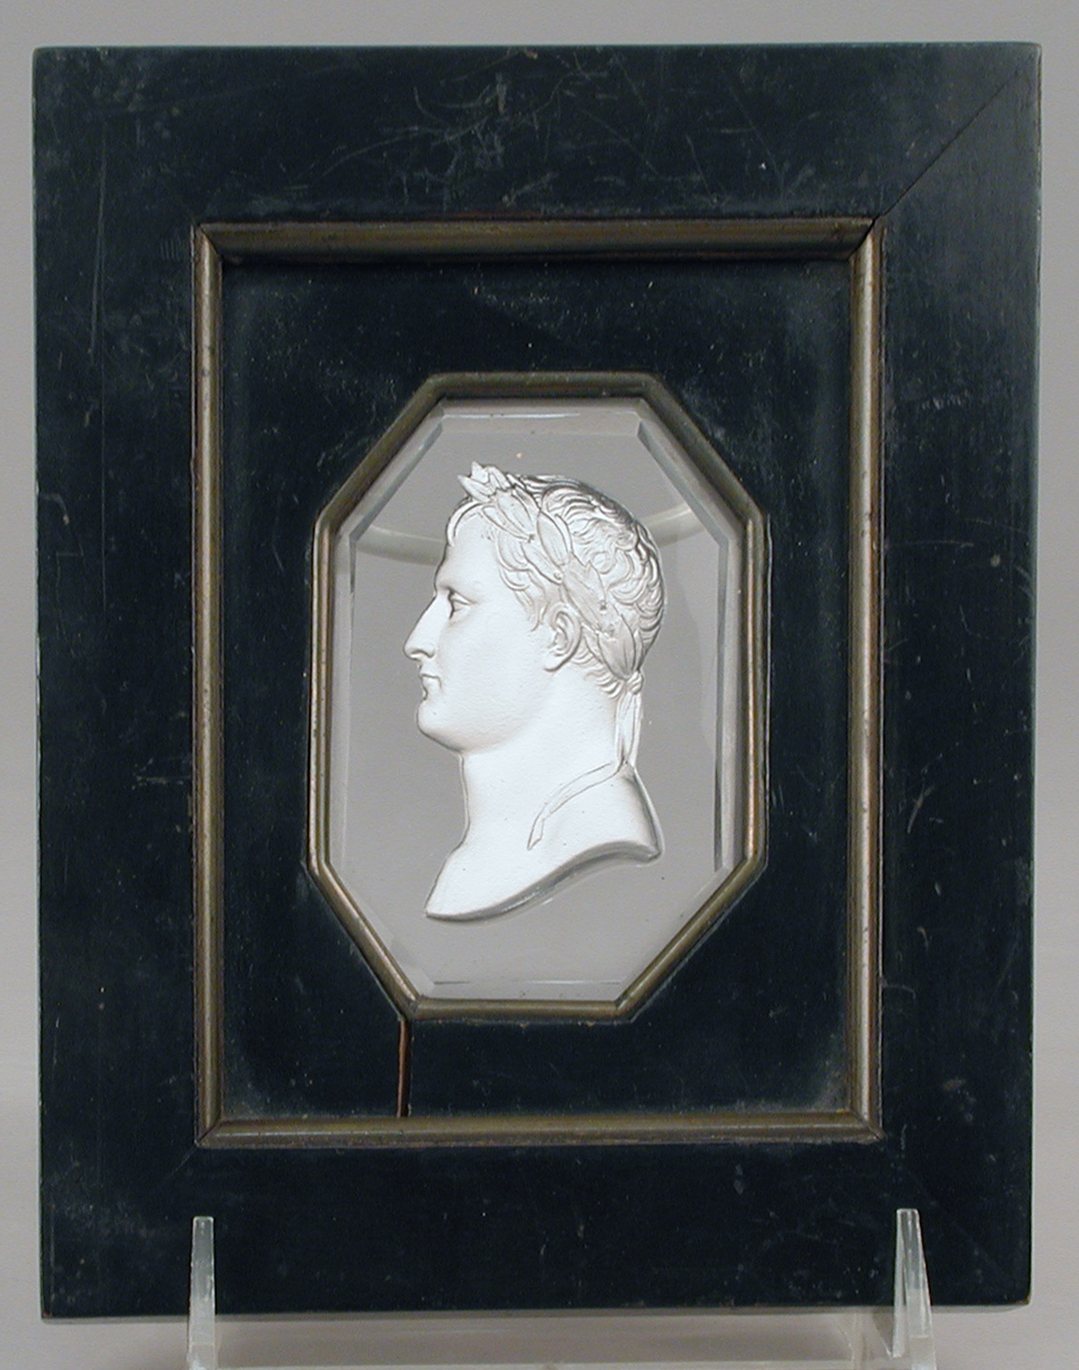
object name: medallion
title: Napoleon I (1769–1821), Emperor of the French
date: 1811-1814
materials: brass, ceramic, glass, paste, wood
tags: napoleon i,profiles